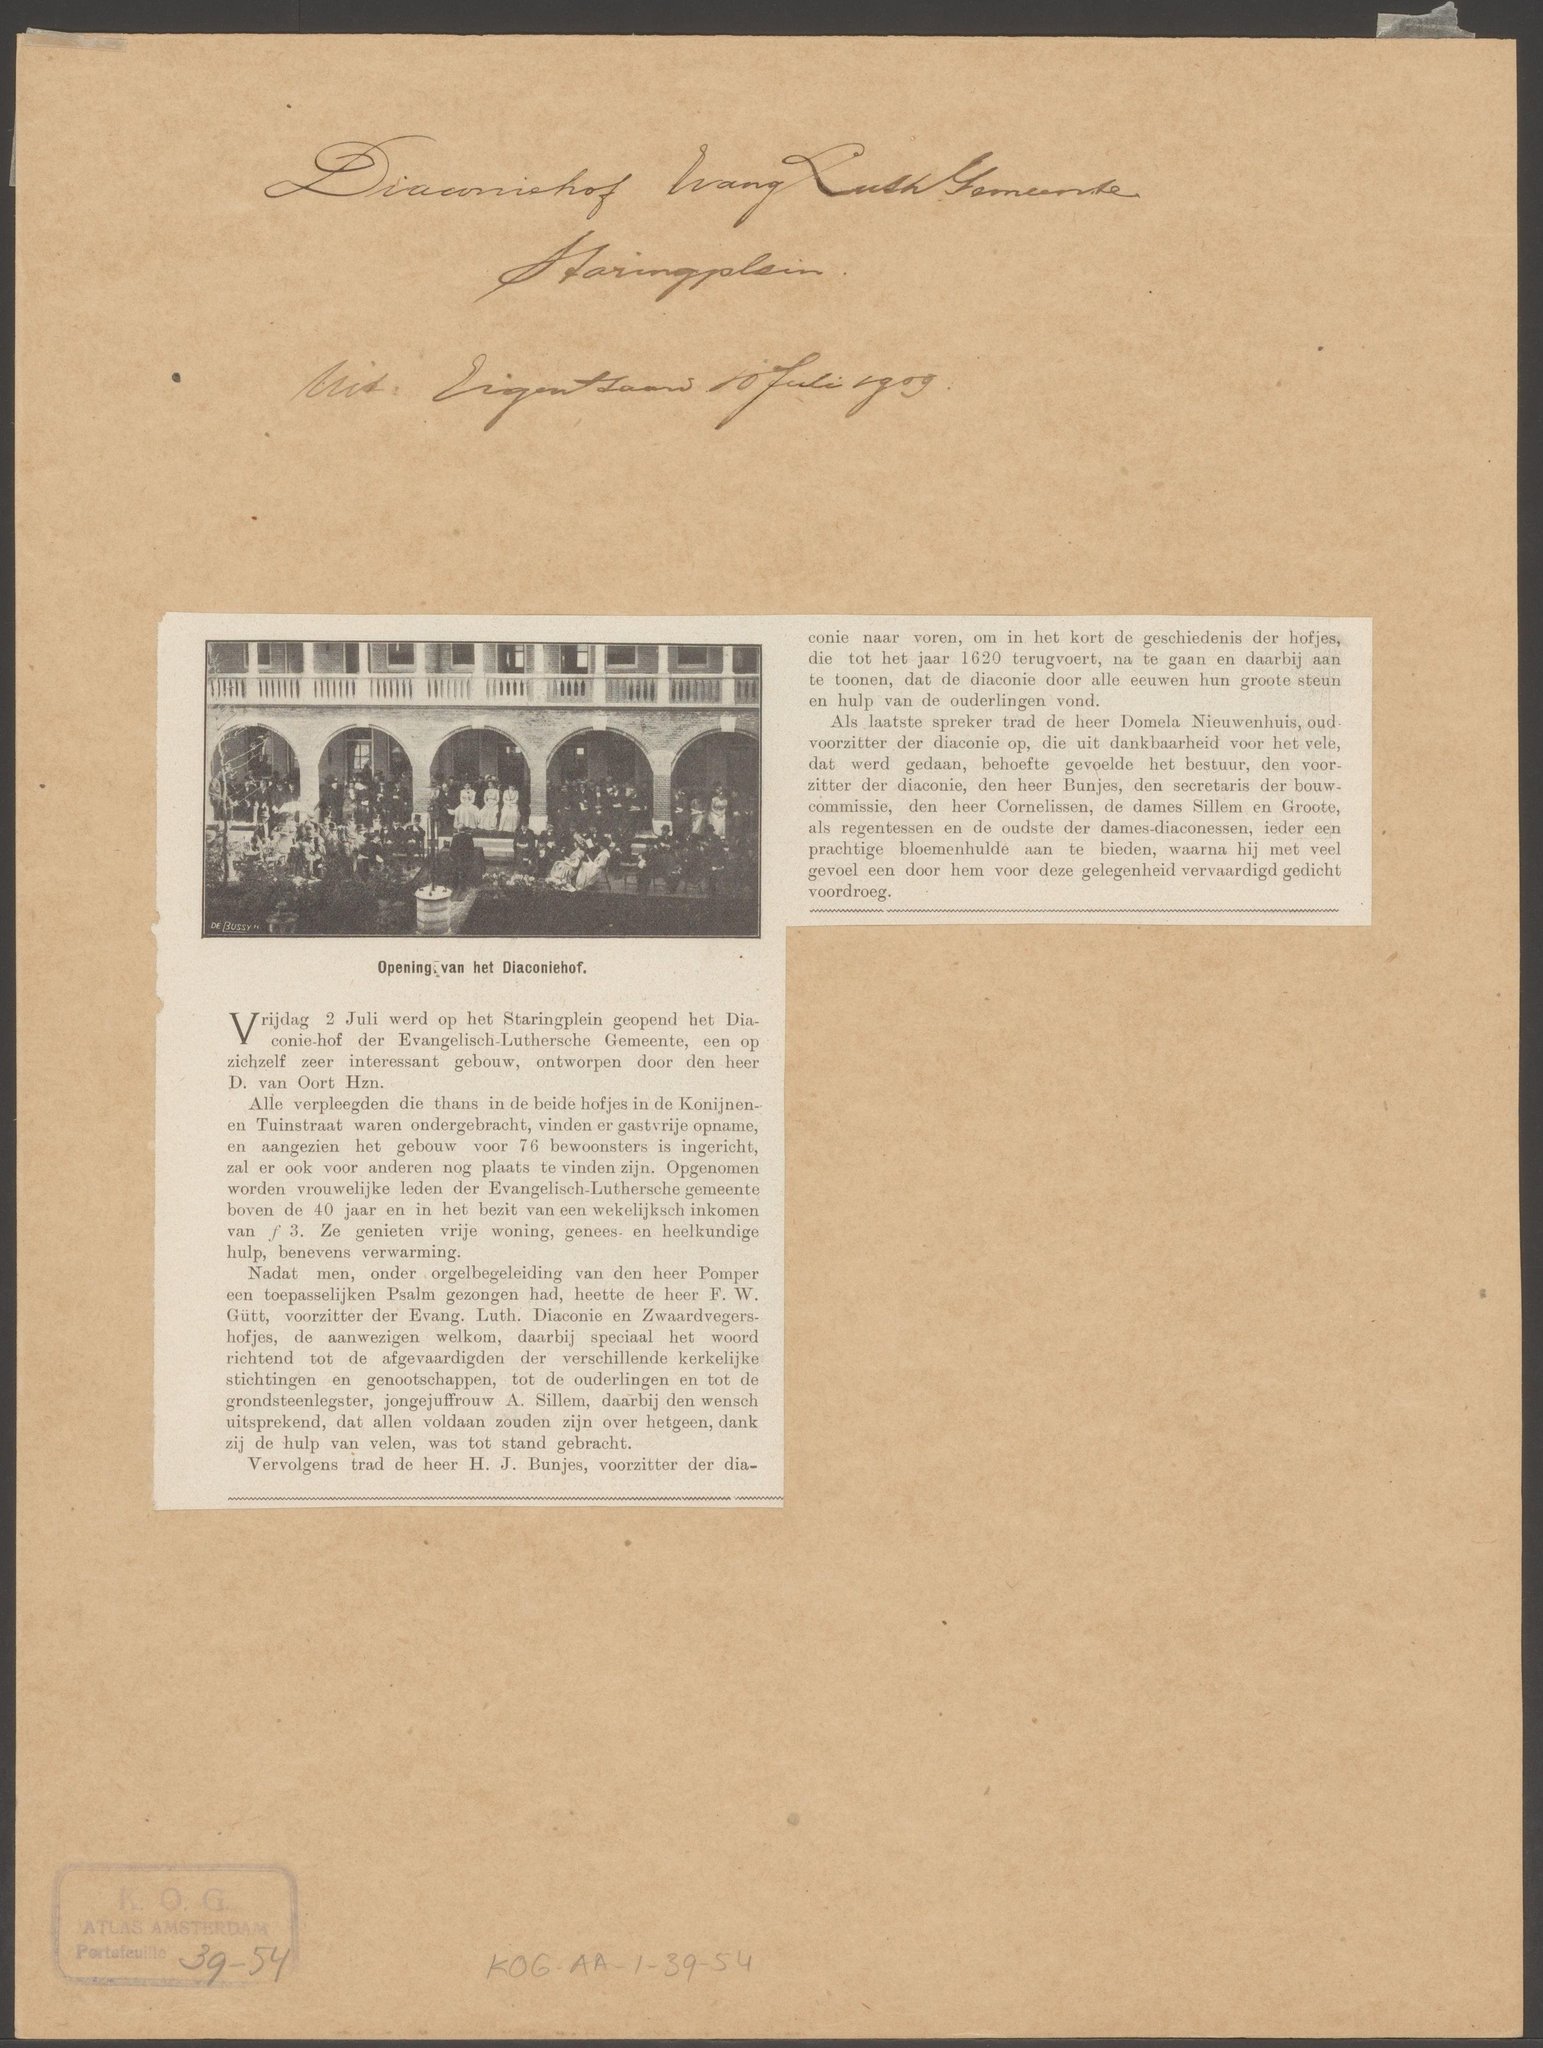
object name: photomechanical print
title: Opening van het Diaconiehof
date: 1909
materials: paper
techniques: letterpress printing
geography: amsterdam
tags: alms-house (dutch: 'hofje')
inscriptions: collector's mark: Lugt 1641b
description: Onderwerpsrubriek binnen de Atlas Amsterdam: Armwezen en liefdadige instellingen: III. Verschillende gestichten en instellingen / Hofjes: Evangelisch-Luthers Diaconiehof - Fontaine’s Hofje - Cyrill's Hofje.